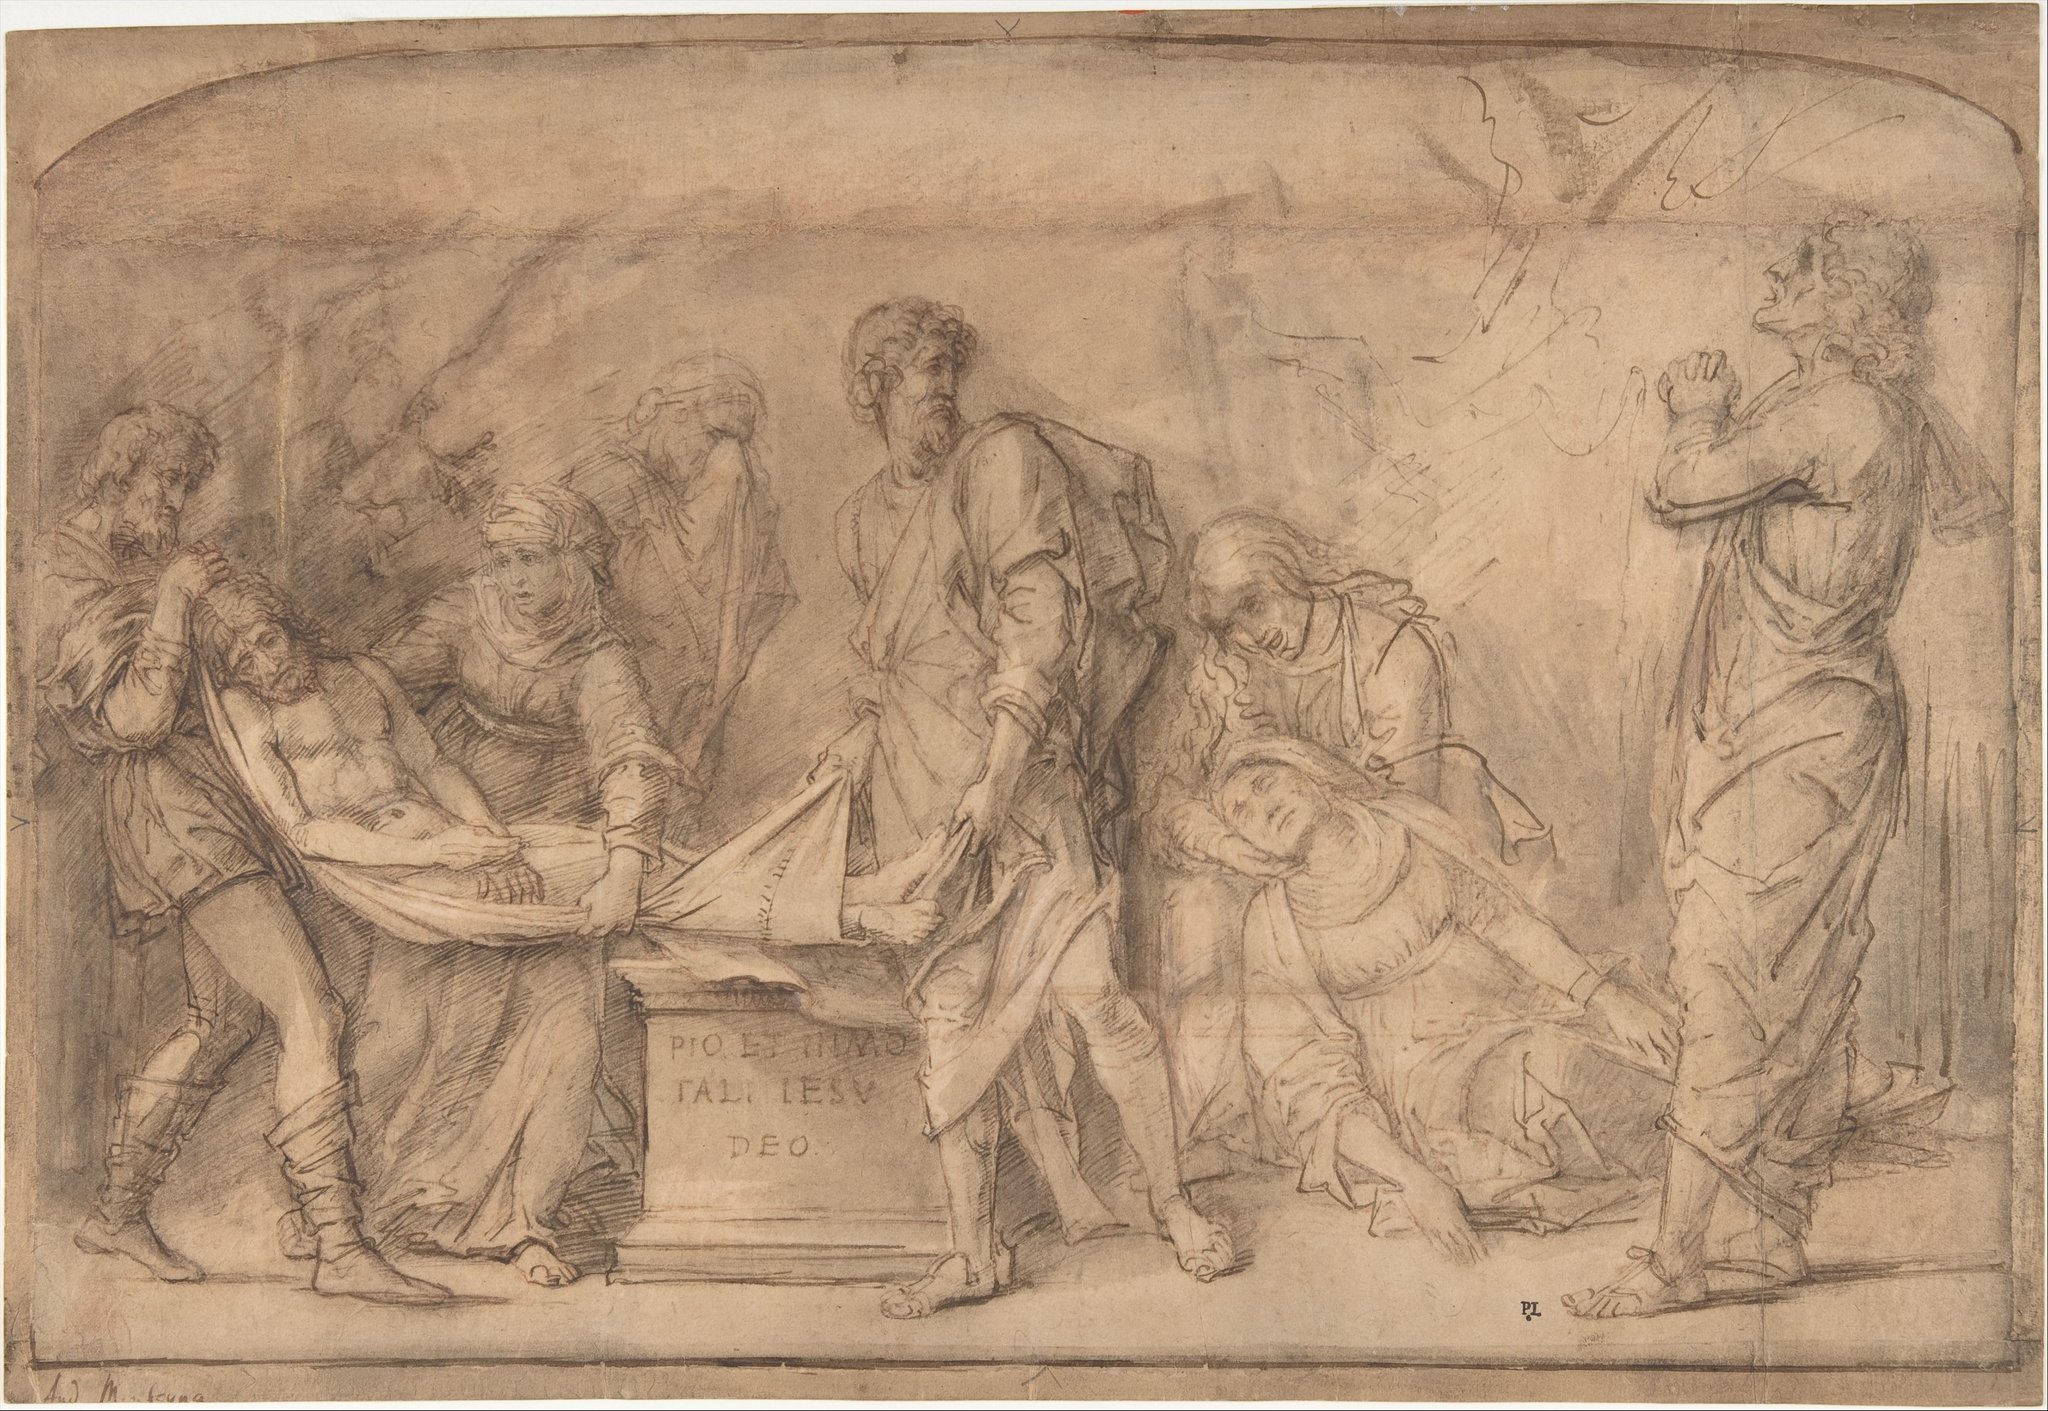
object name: drawing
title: The Entombment, after Mantegna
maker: rembrandt van rijn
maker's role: artist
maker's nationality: dutch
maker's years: 1606-1669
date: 1601-1700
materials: chalk, ink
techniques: brush, heightening, pen, wash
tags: sadness,men,women,christ,entombment